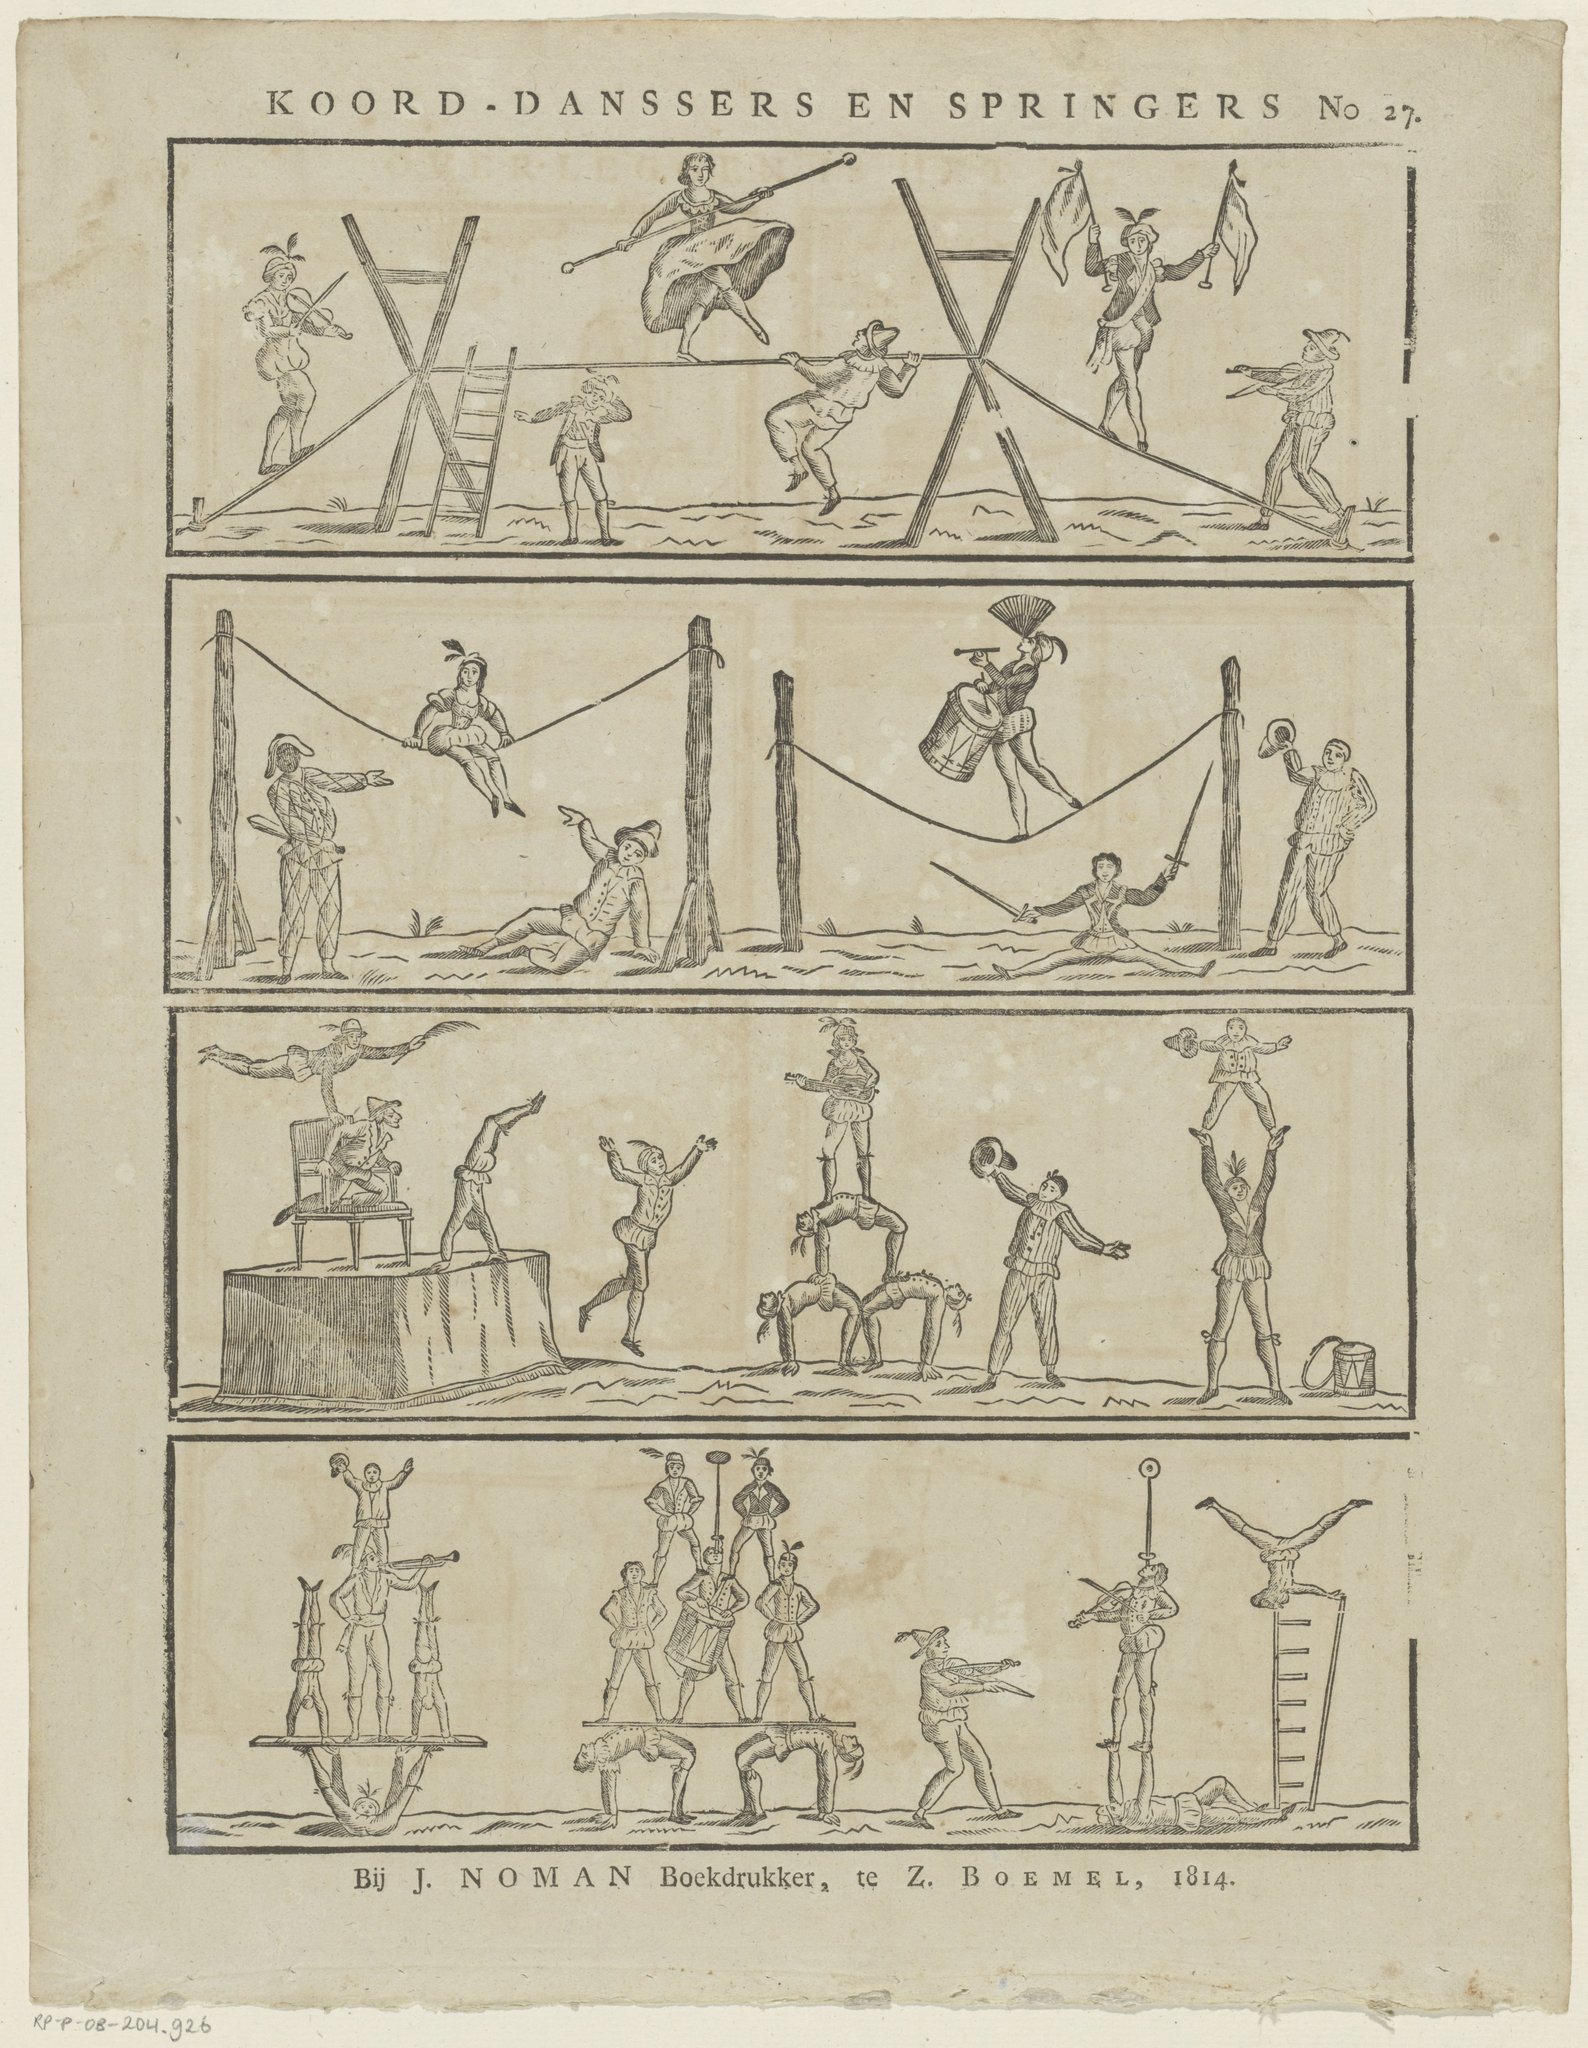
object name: popular print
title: Koord-danssers en springers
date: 1806-1830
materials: paper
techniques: letterpress printing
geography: zaltbommel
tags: equilibrist, acrobat ~ circus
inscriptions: collector's mark: Lugt 2760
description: Blad met 4 voorstellingen van circusartiesten, zoals koorddansers en acrobaten. Genummerd rechtsboven: No 27.